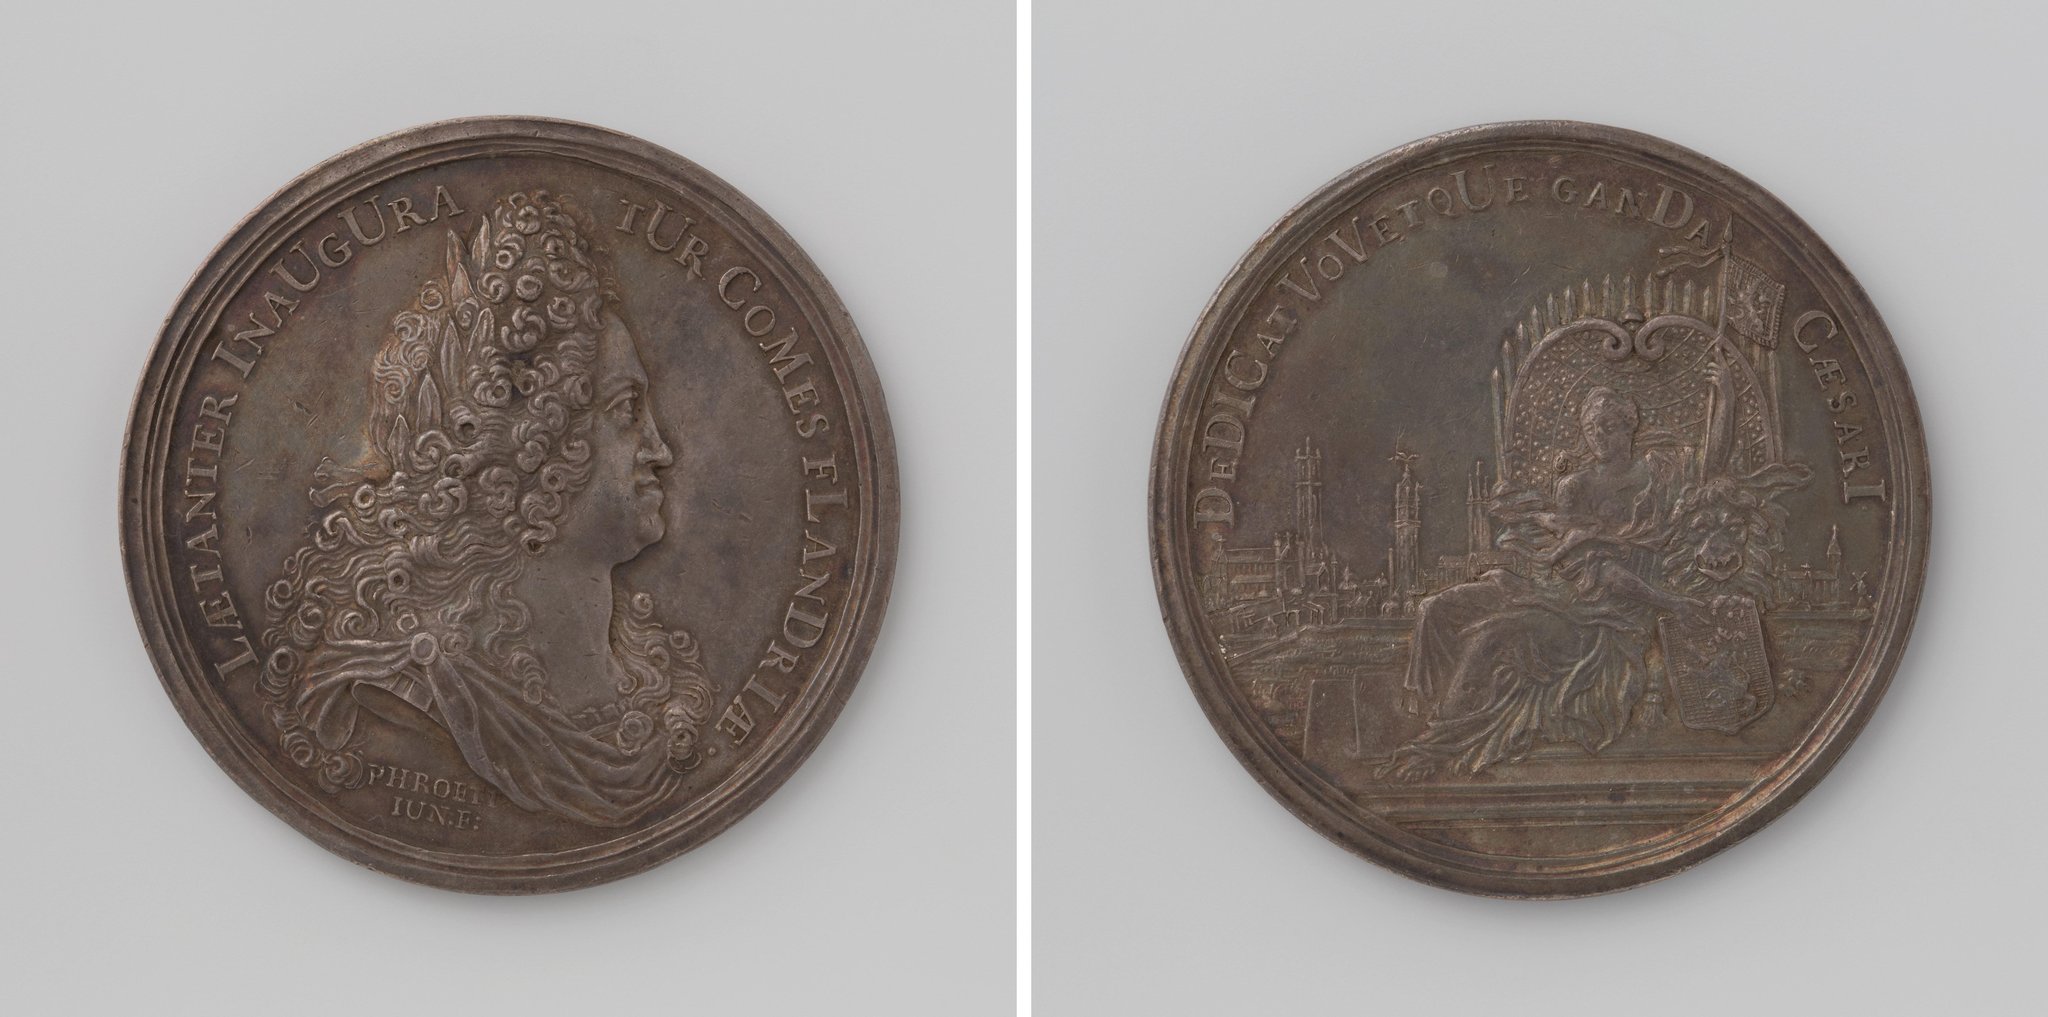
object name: history medal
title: Inhuldiging van Karel VI als graaf van Vlaanderen, penning geslagen door de stad Gent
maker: philippe roëttiers (iii)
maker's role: medailleur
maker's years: 1686-1873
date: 1717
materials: silver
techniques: striking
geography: antwerp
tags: vienna, charles vi (holy roman emperor), ghent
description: Zilveren penning. Voorzijde: borststuk man met lauwerkrans binnen omschrift. Keerzijde: Gent, in gedaante van jonge vrouw zit op troon met in haar linkerhand een banier, met haar rechter wijzend op wapenschild dat wordt vastgehouden door leeuw, op achtergrond gezicht op stad Gent binnen omschrift.